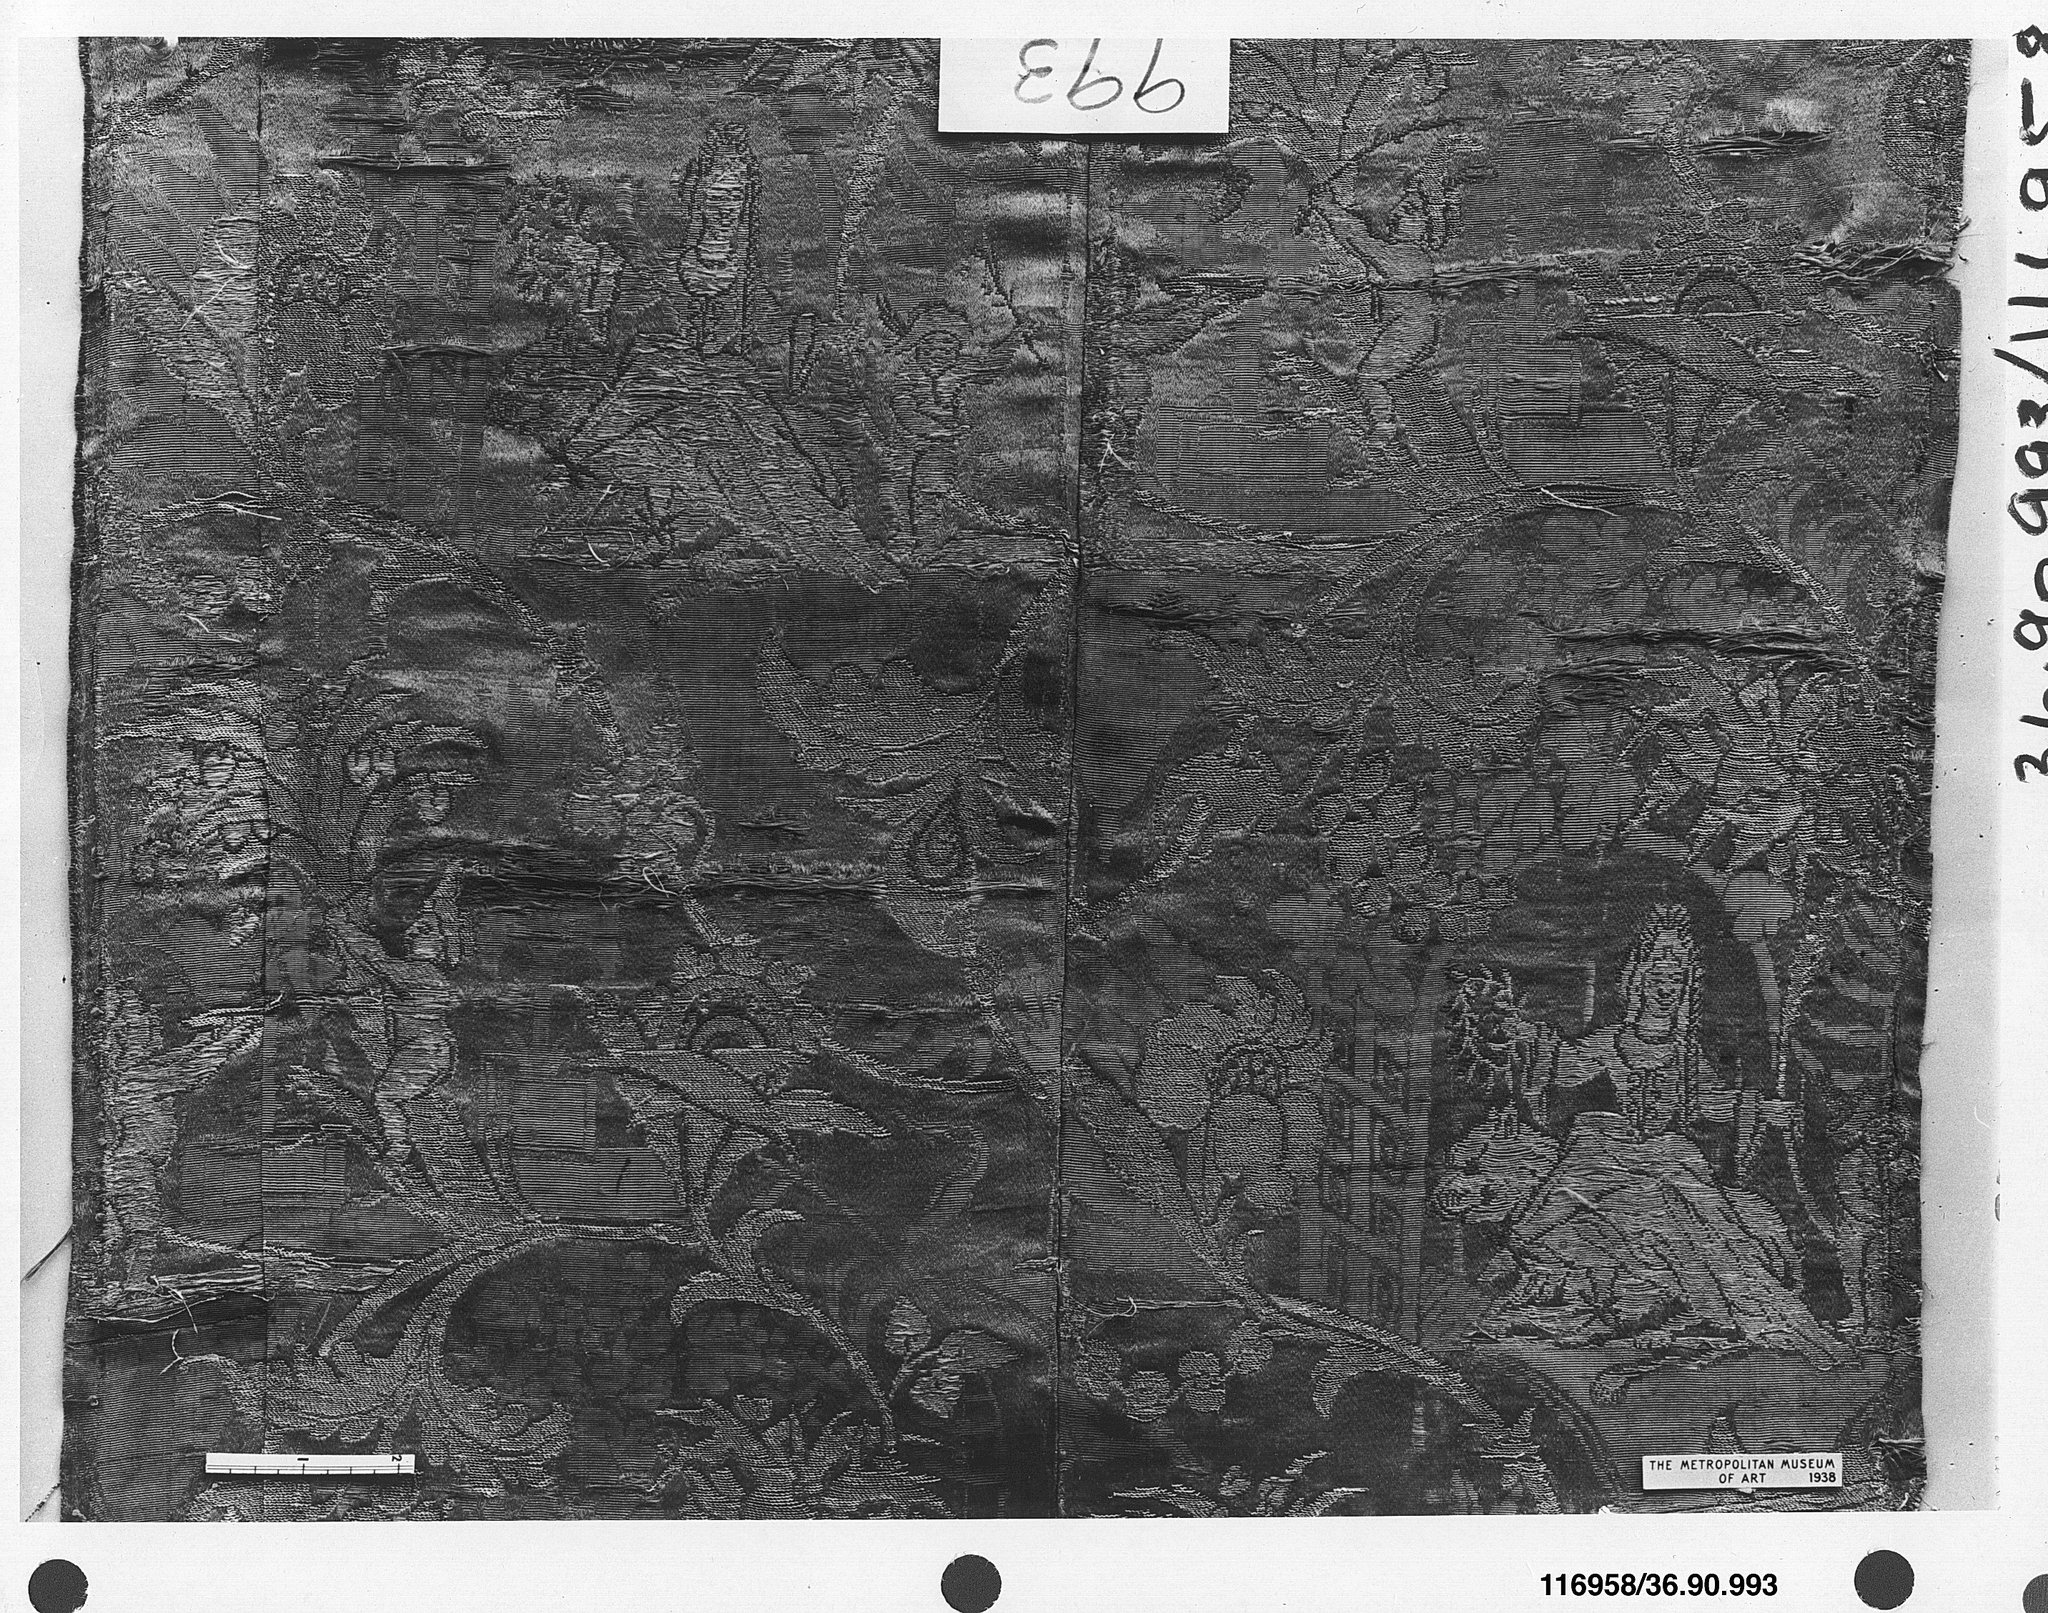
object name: piece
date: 1700-1715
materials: metal thread, silk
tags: human figures,animals,flowers